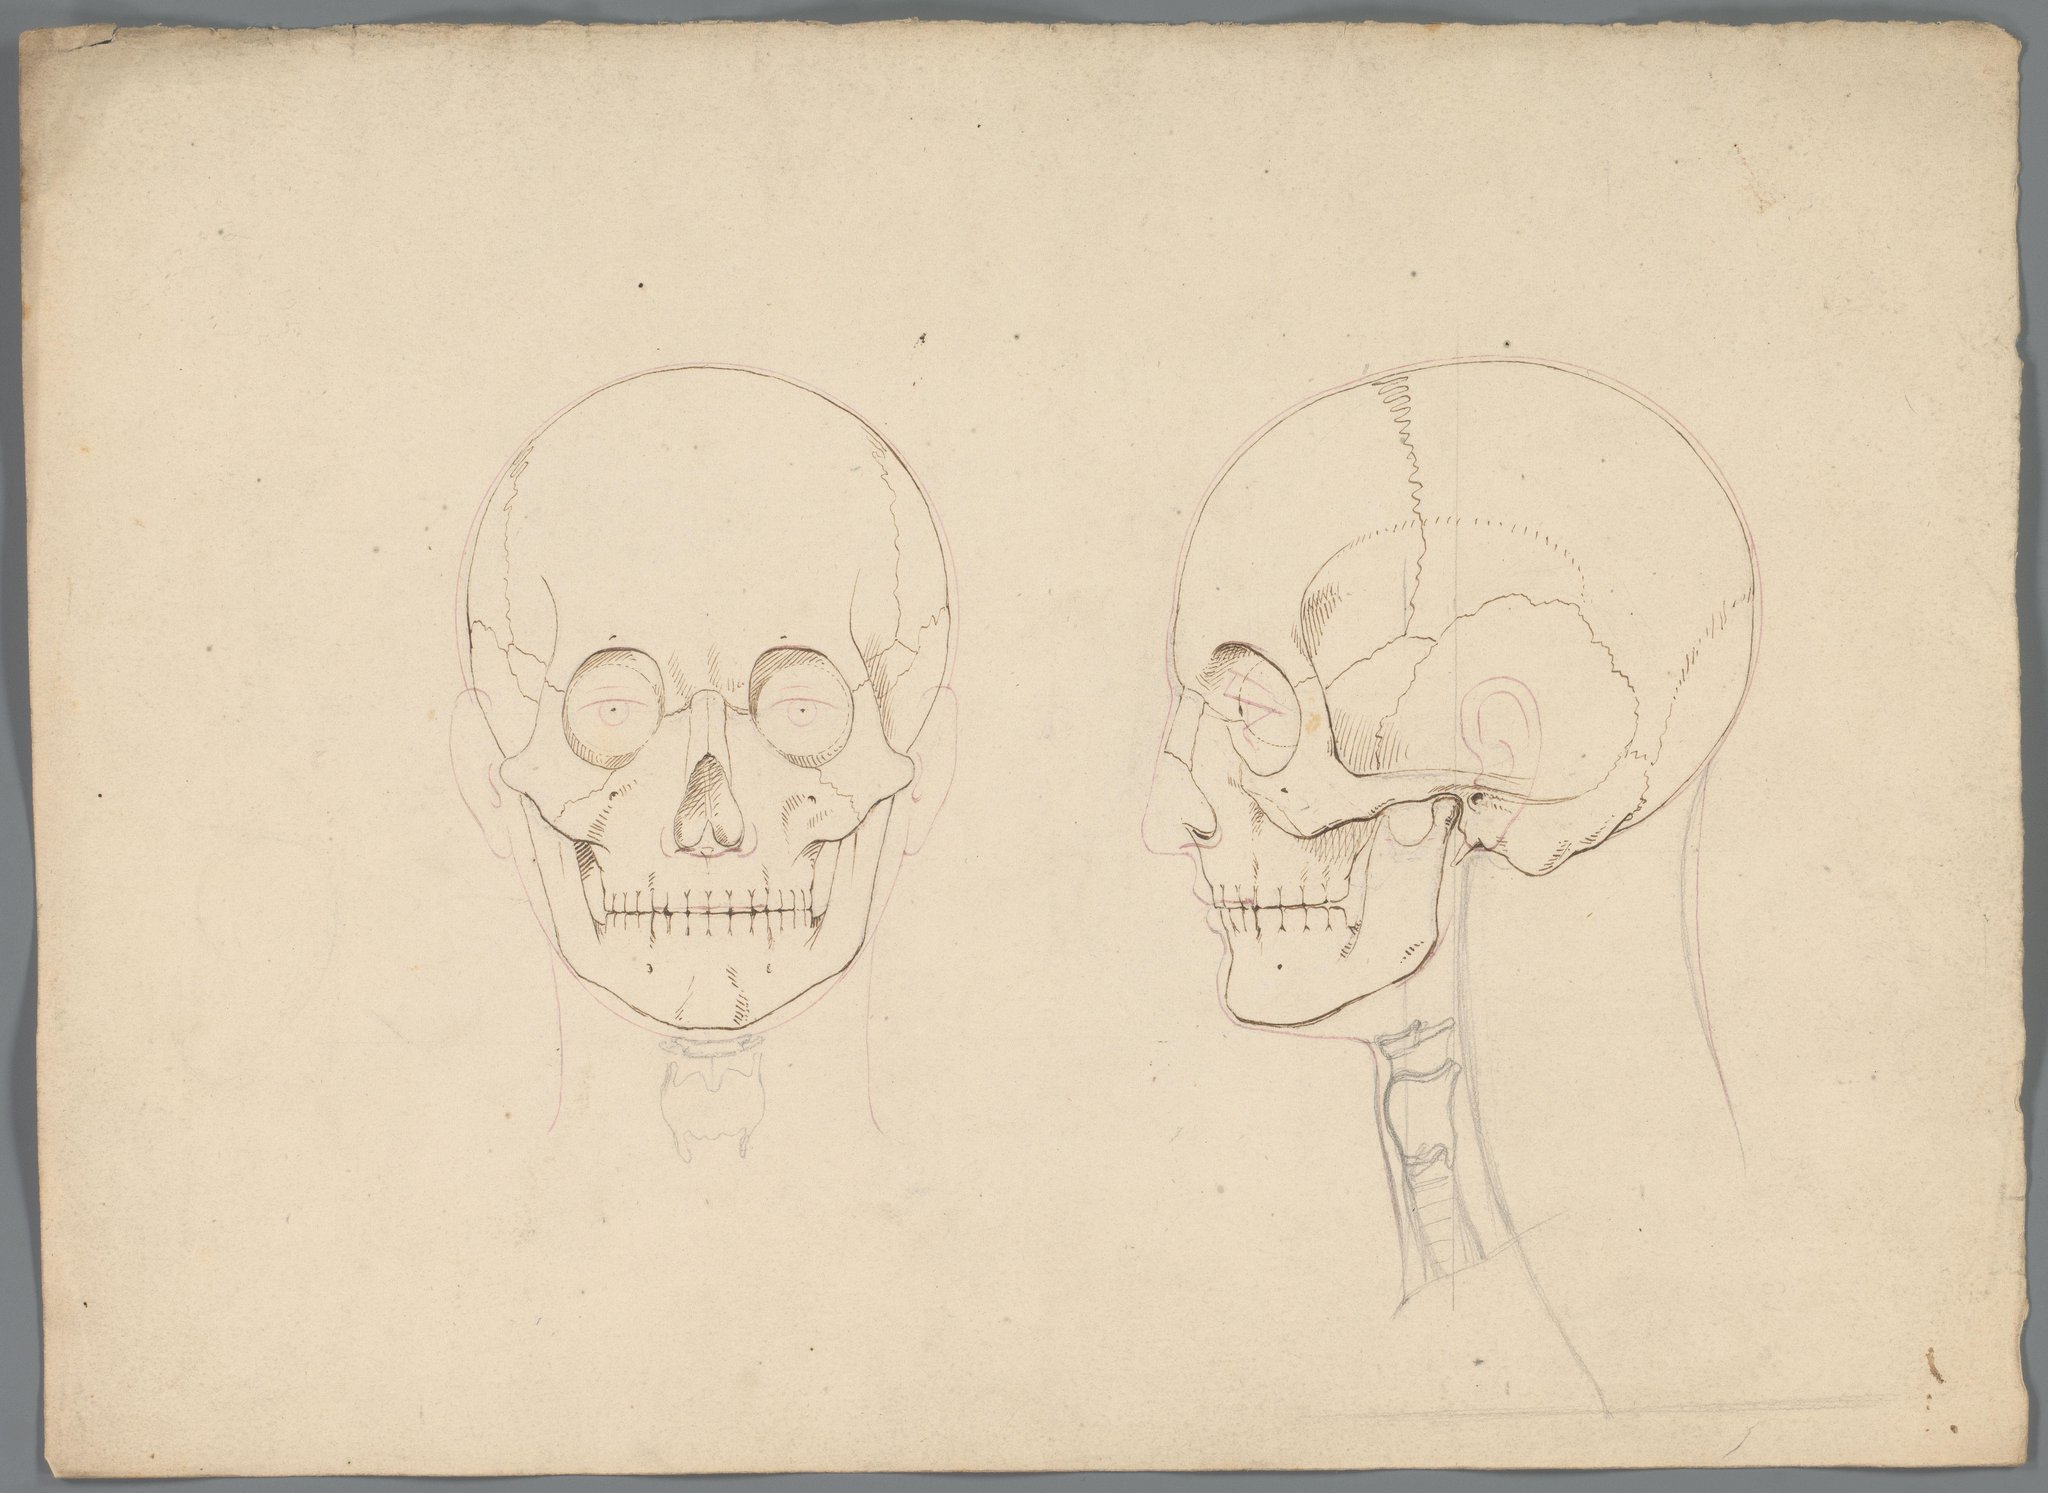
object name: drawing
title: Studie van een schedel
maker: jacobus everhardus josephus van den berg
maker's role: draughtsman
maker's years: 1802-1861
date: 1812-1861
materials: ink, paper, pencil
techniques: pen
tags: (human) skull